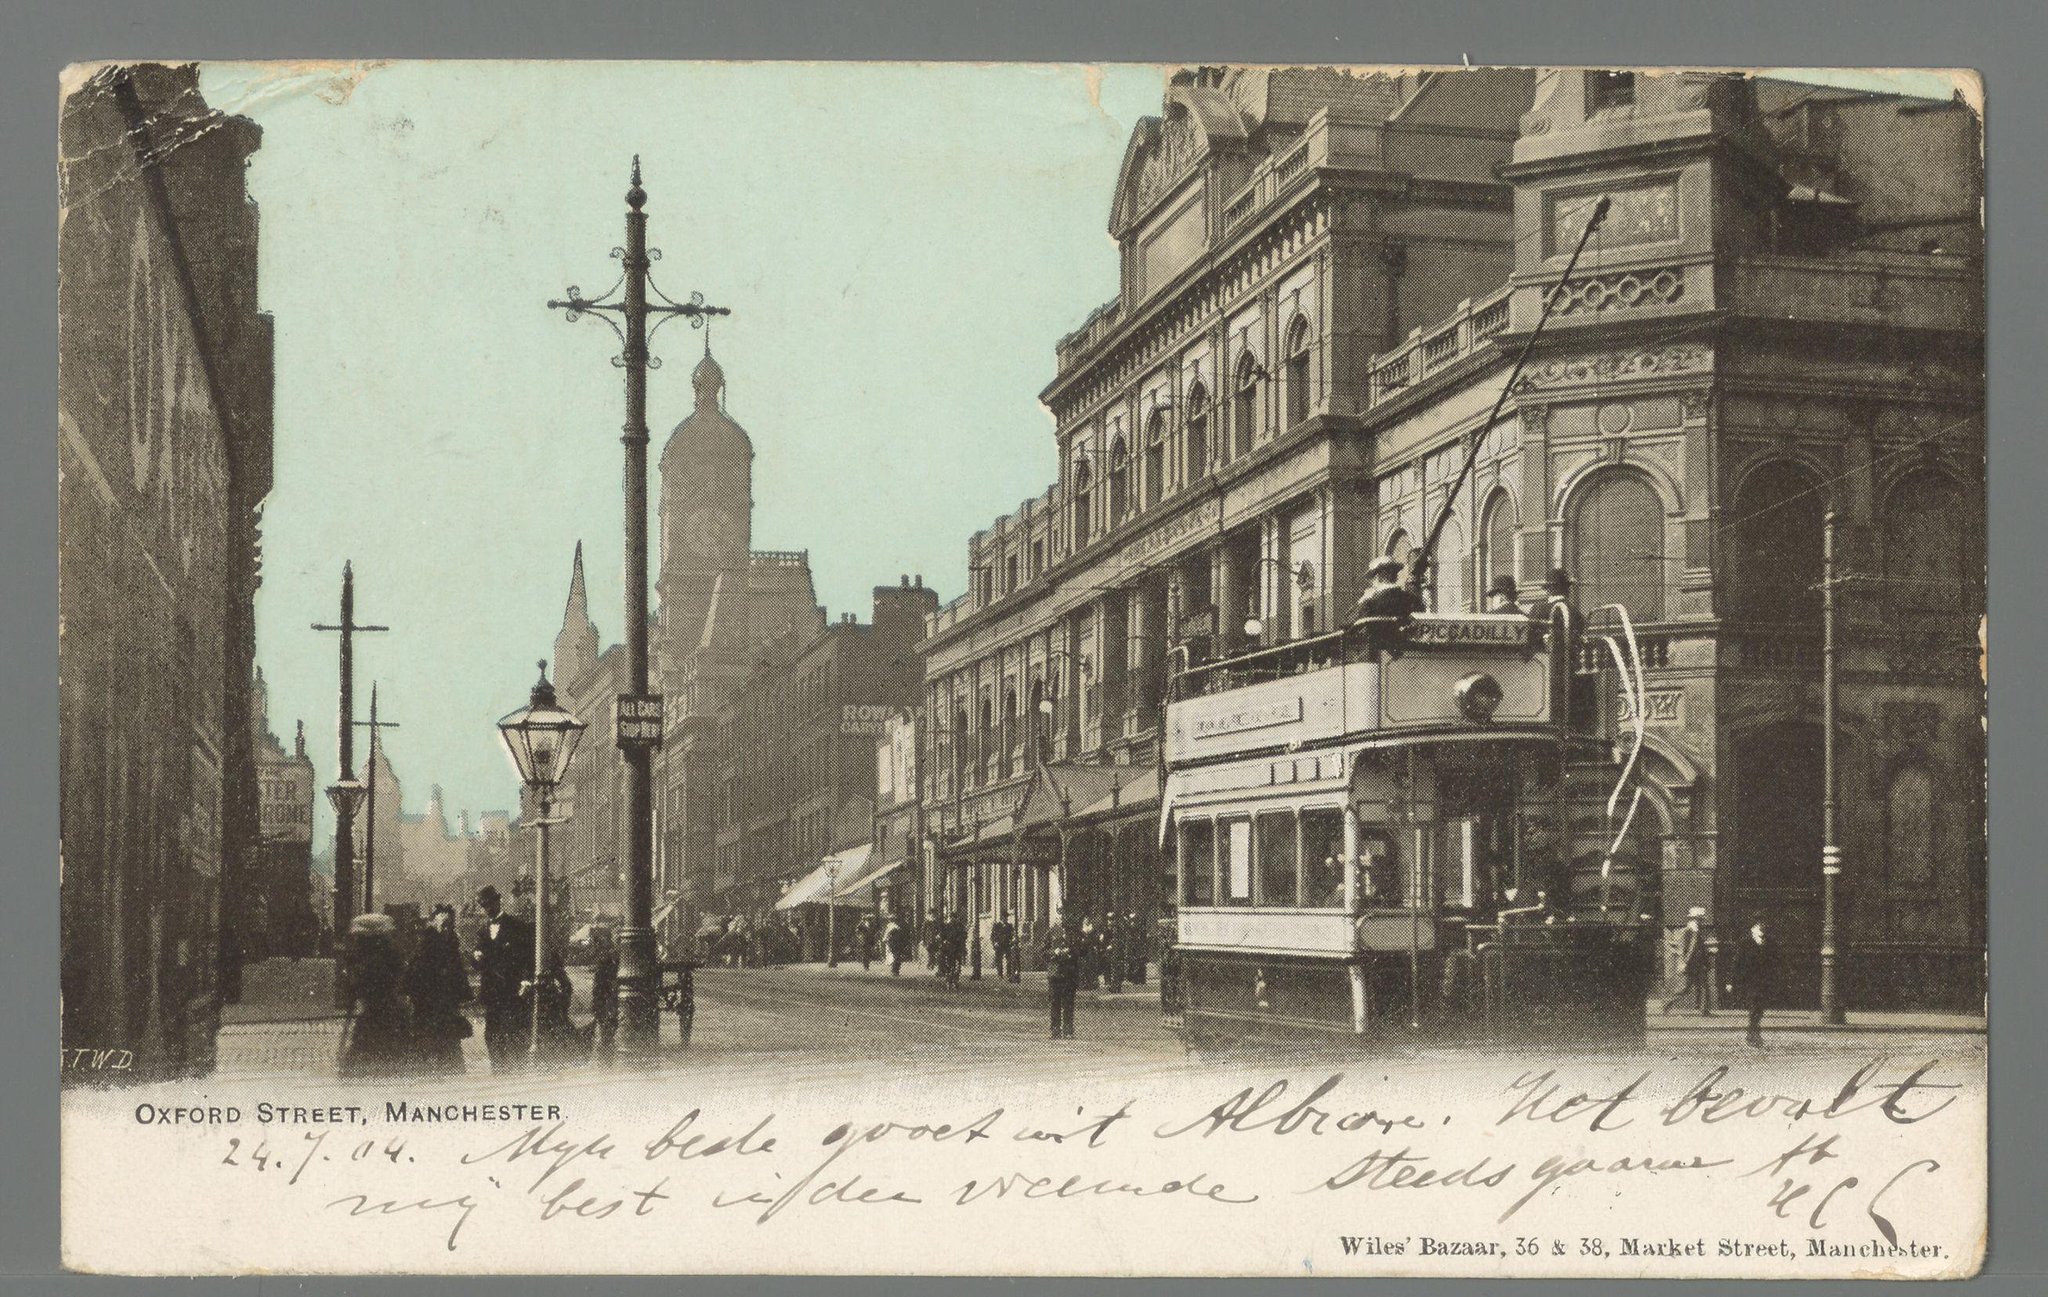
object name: ansichtkaart, prentbriefkaart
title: Oxford Street, Manchester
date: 1903-1904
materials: cardboard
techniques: lithograph, writing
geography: edinburgh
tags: tram, street, manchester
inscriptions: postage stamp